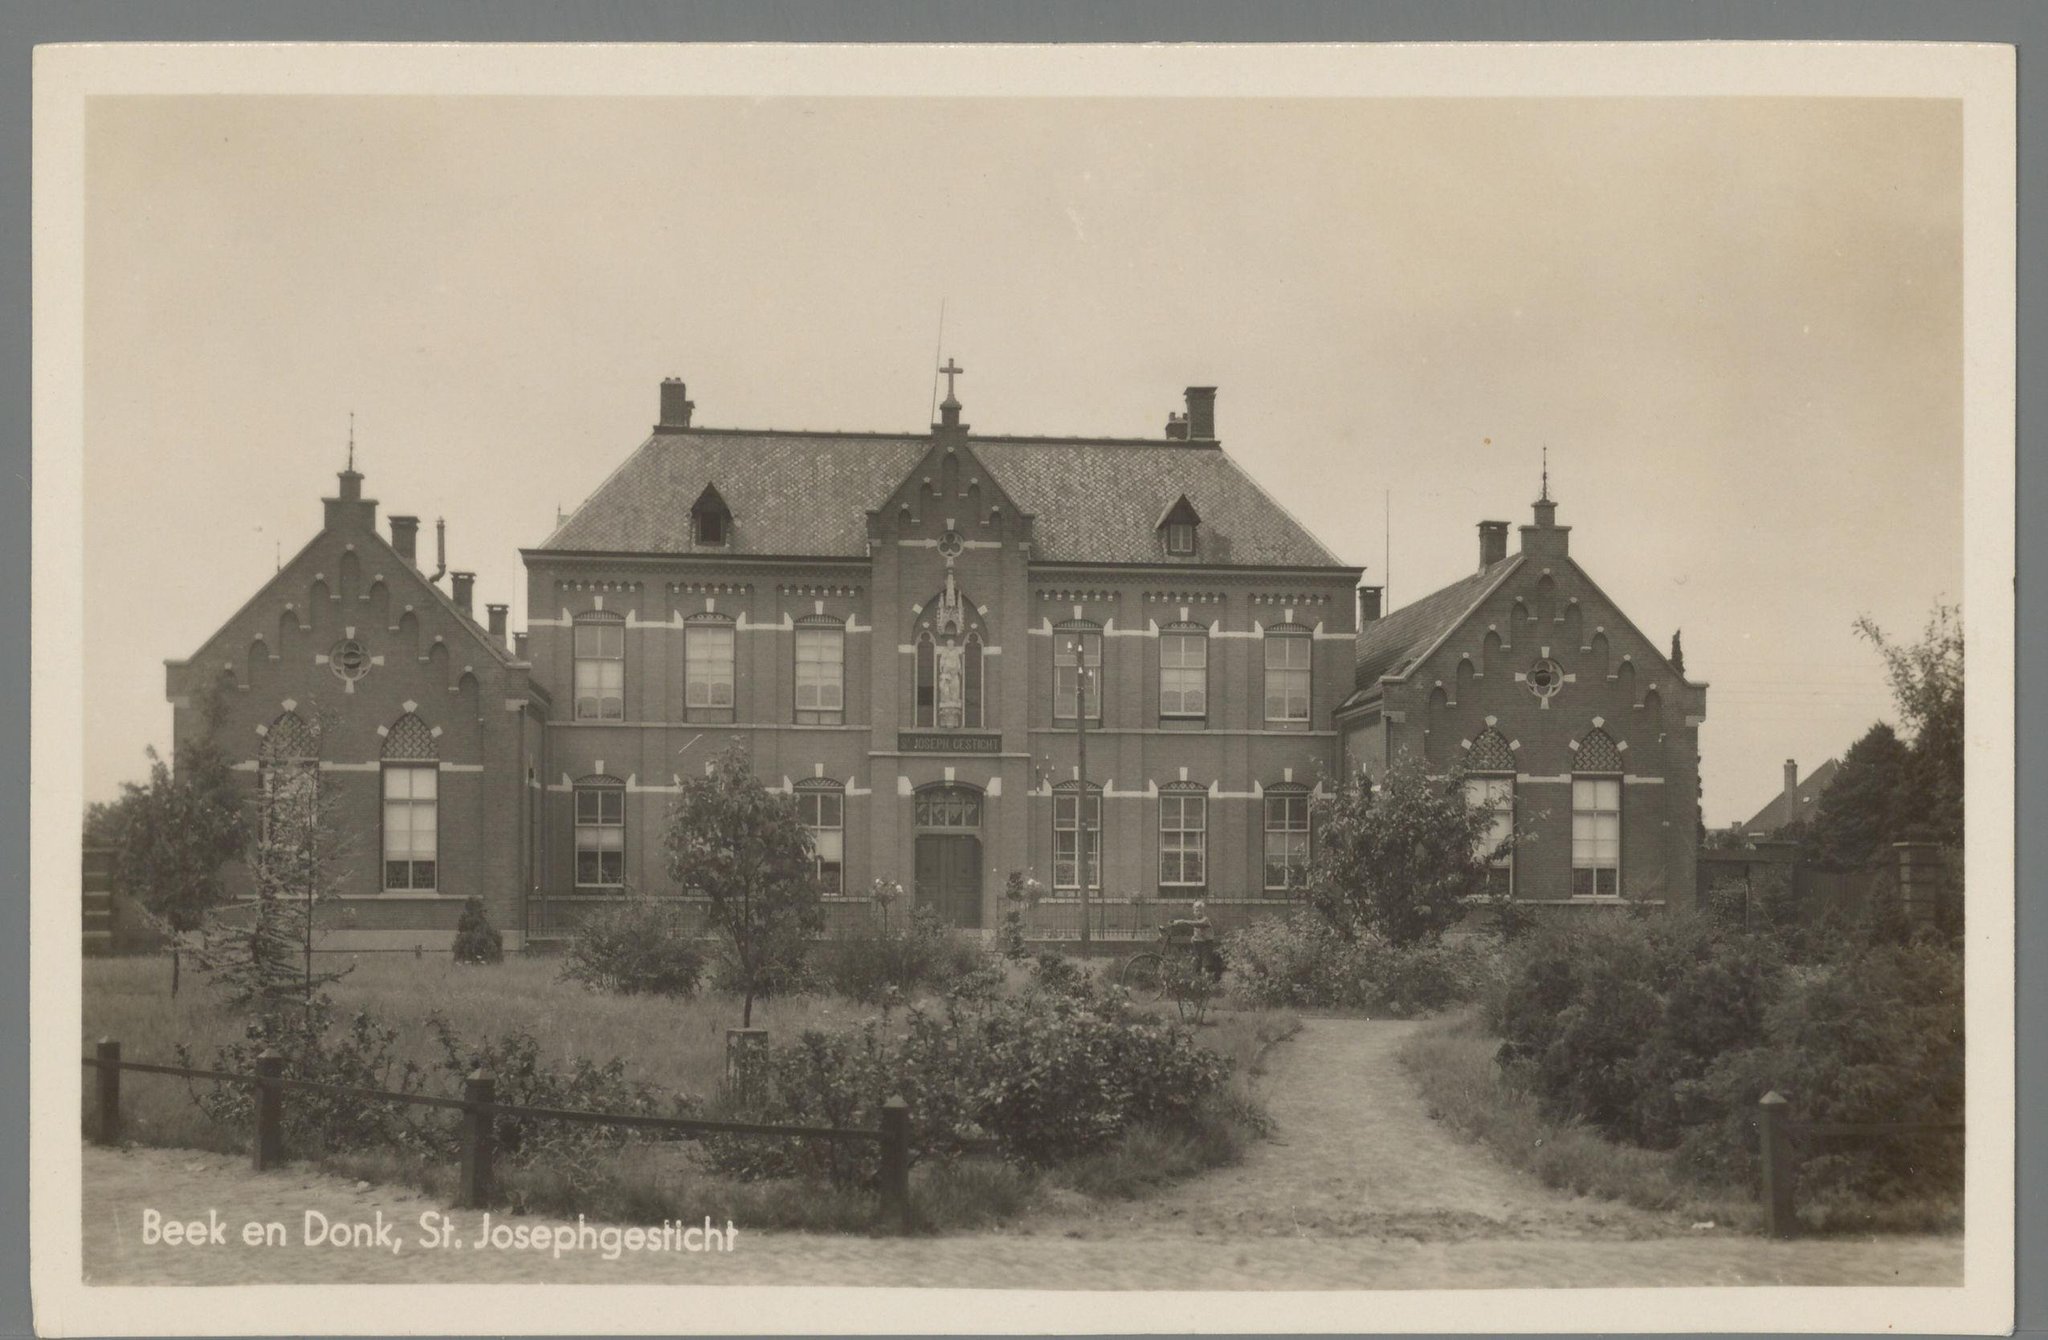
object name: photograph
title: Beek en Donk, St. Josephgesticht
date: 1908-1941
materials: paper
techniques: gelatin silver print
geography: arnhem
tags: lunatic asylum, mental home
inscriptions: date